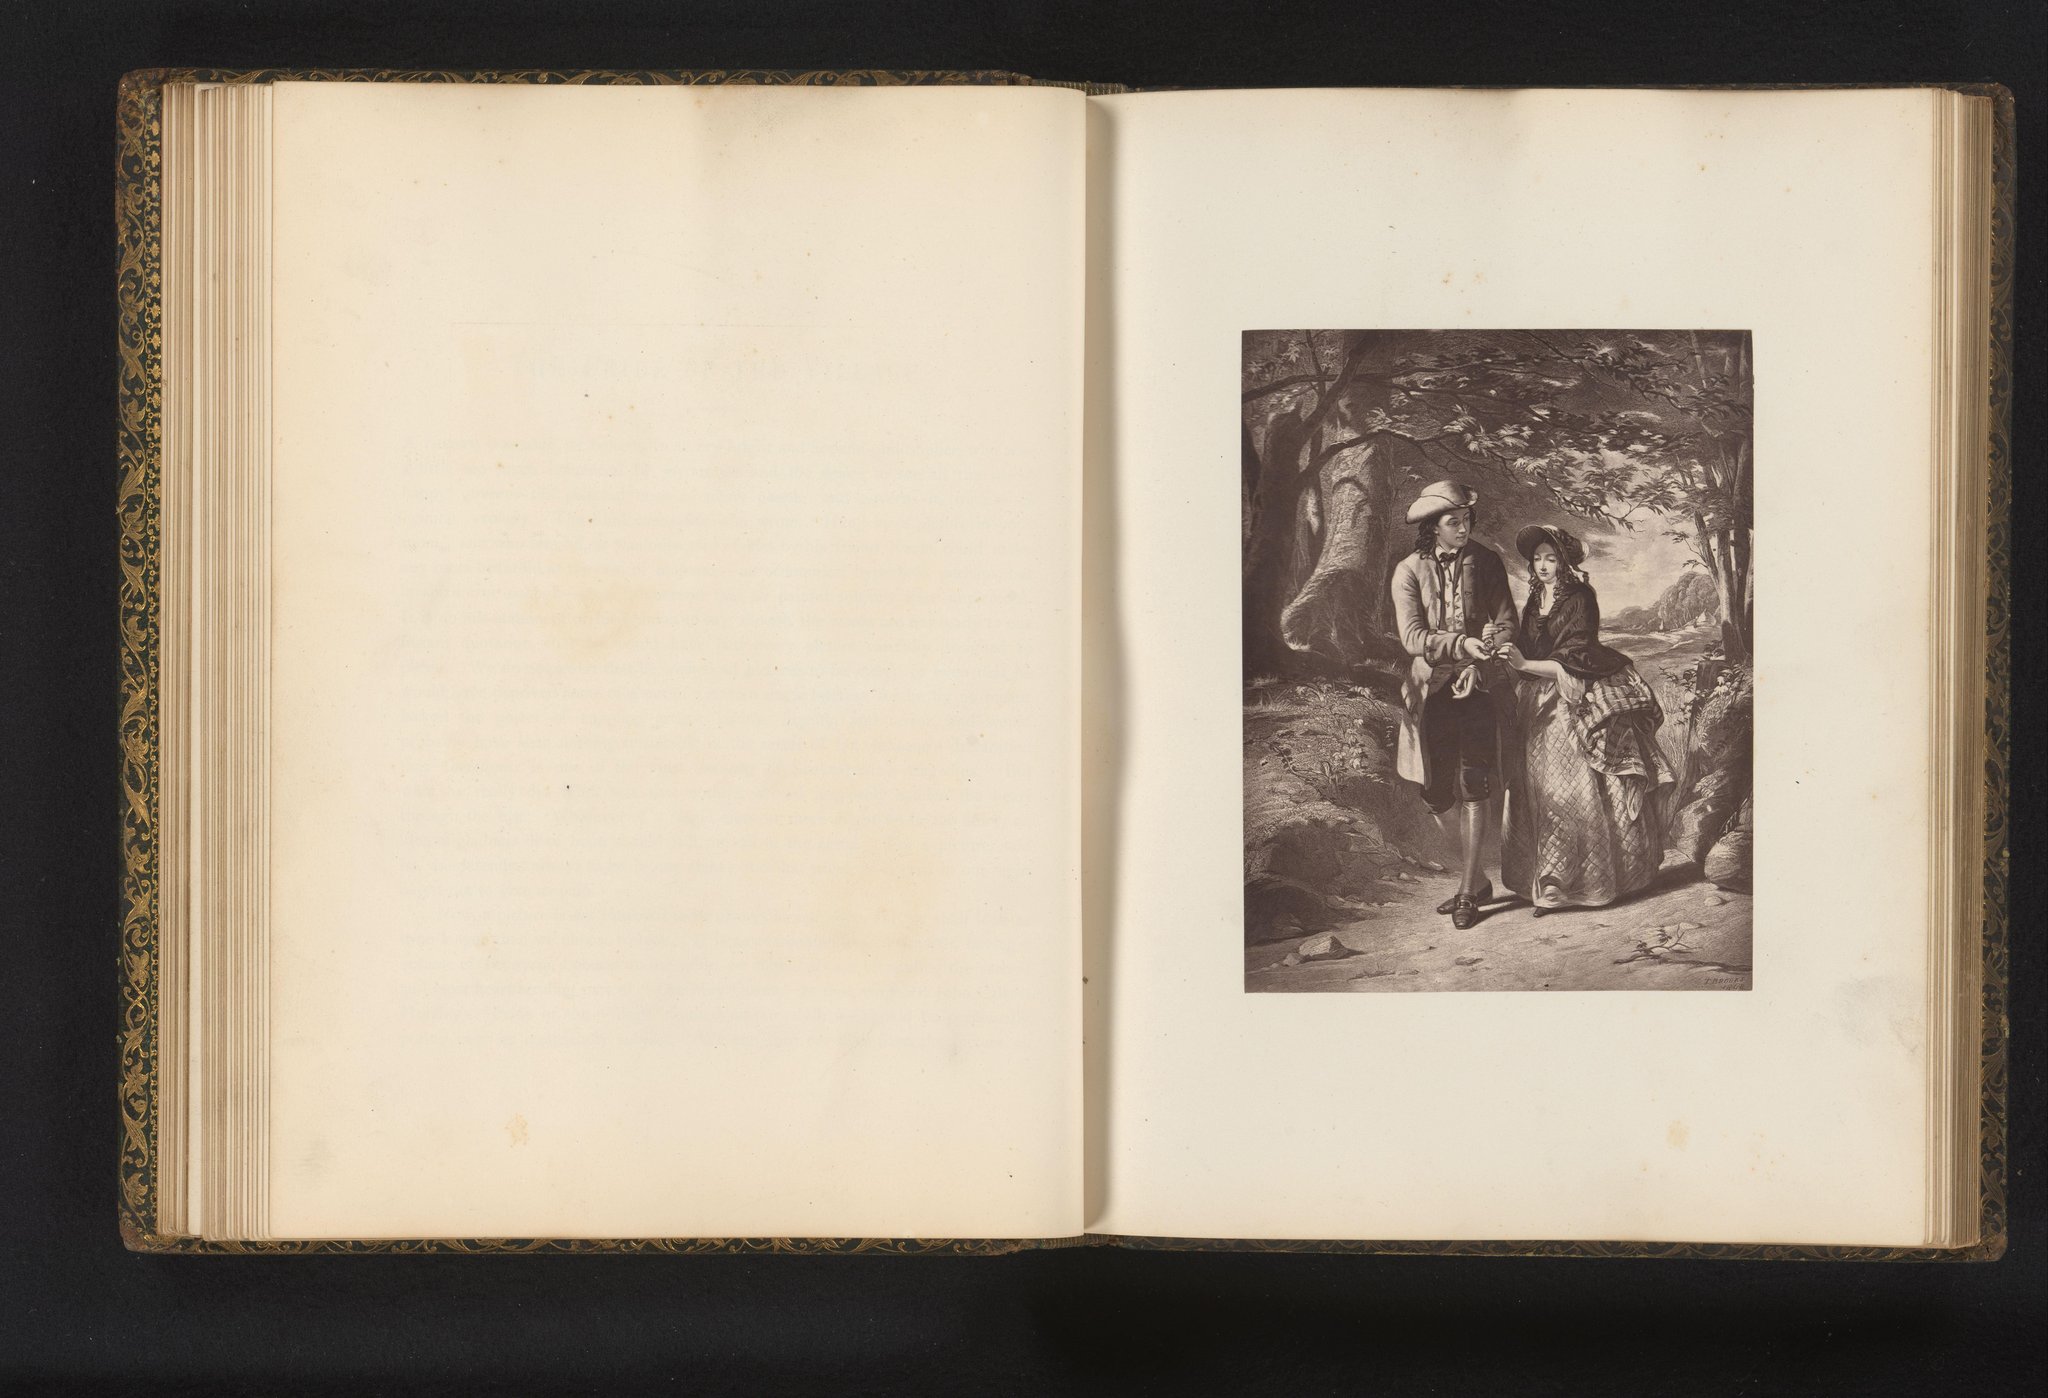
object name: page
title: Fotoreproductie van een gravure naar het schilderij The village rose door Thomas Brooks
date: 1866-1871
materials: paper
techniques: woodburytype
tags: print, e.g.: engraving, etching, lithograph, arm in arm (lovers)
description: Prent op derde ongenummerde pagina na pagina 48.